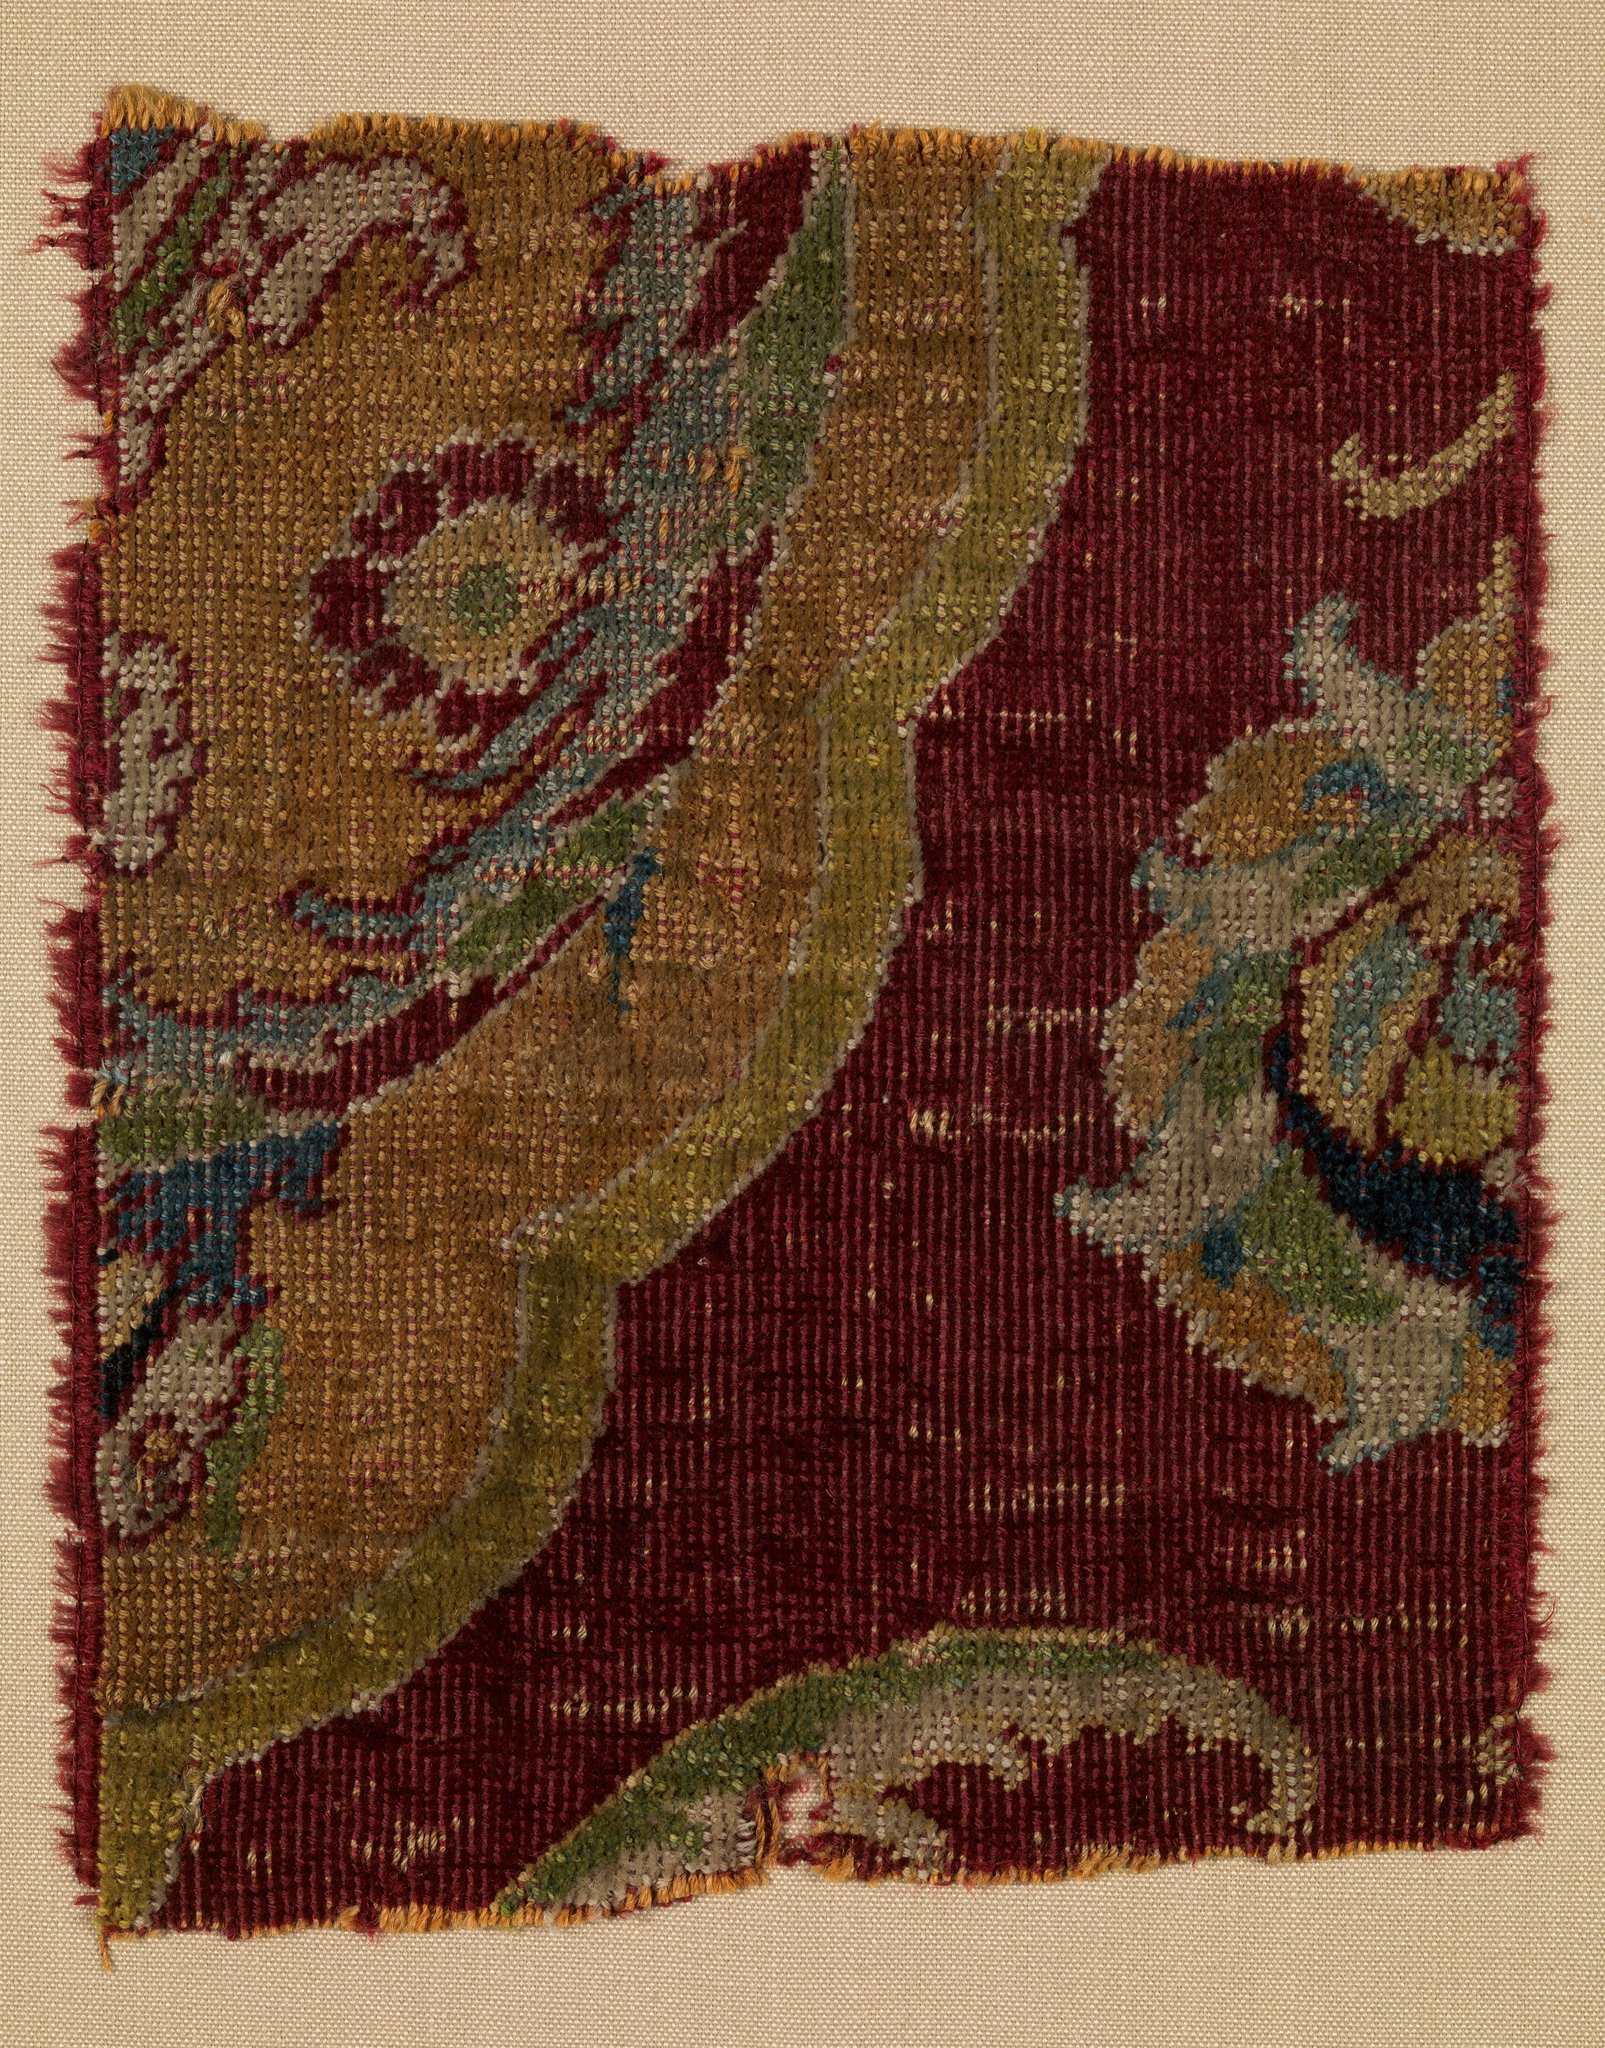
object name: carpet fragment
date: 1601-1700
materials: wool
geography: turkey